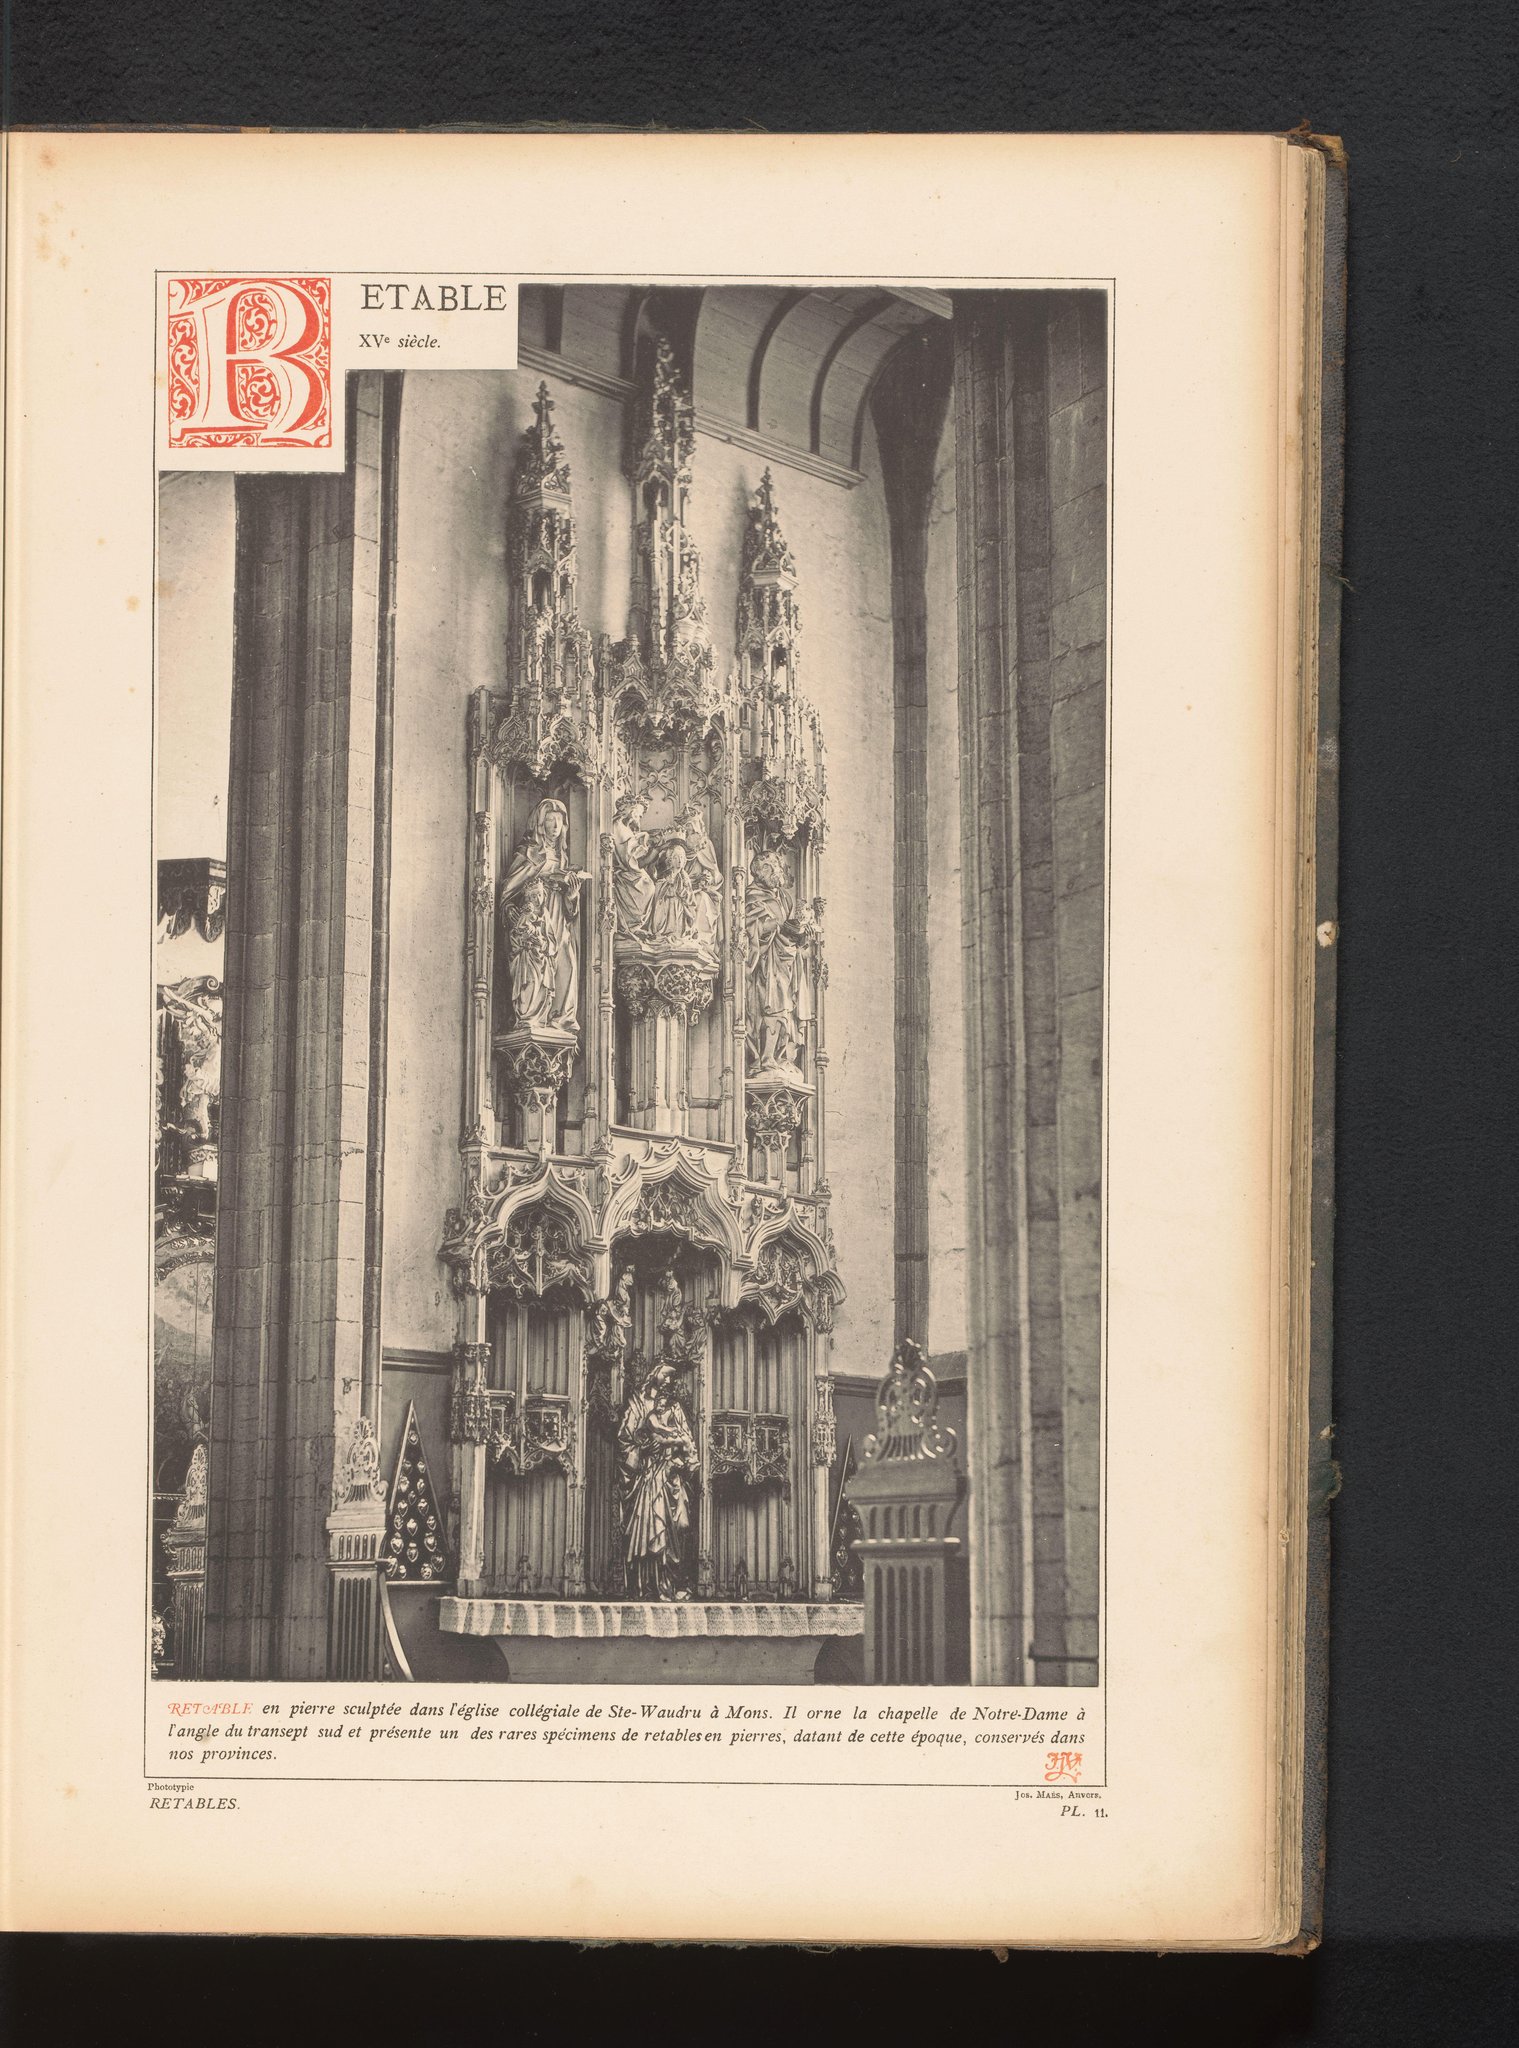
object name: photomechanical print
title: Retable, XVIe siècle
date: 1882-1887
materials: paper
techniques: photograph, photolithography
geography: antwerp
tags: altar with altar-piece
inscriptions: inscription: ‘RETABLES. - PL. 11.’, monogram: ‘JJvY’, inscription: ‘RETABLE en pierre (...)’